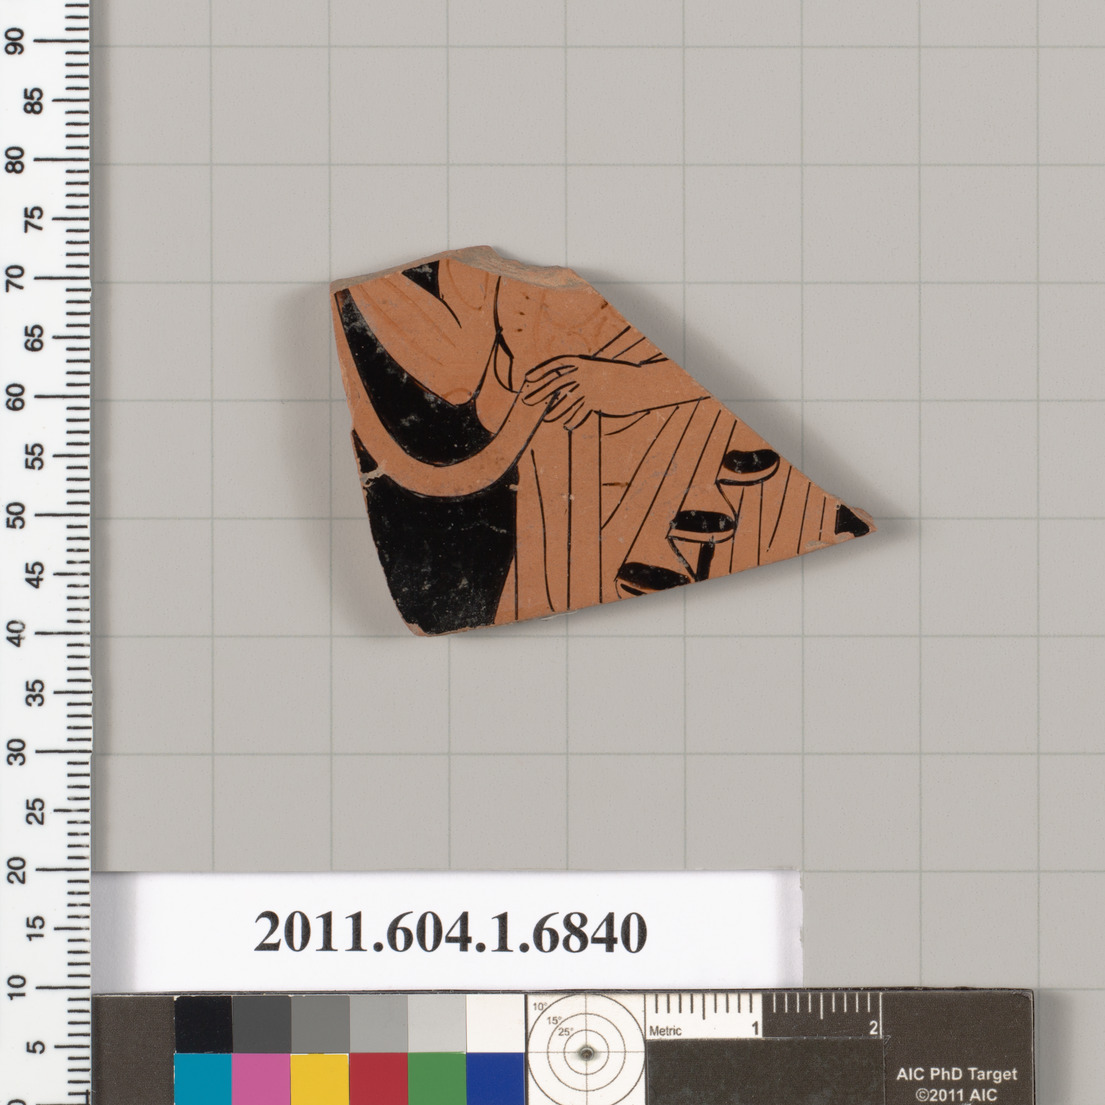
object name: kylix fragment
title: Terracotta fragment of a kylix (drinking cup)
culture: greek, attic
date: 490-470 BCE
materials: terracotta